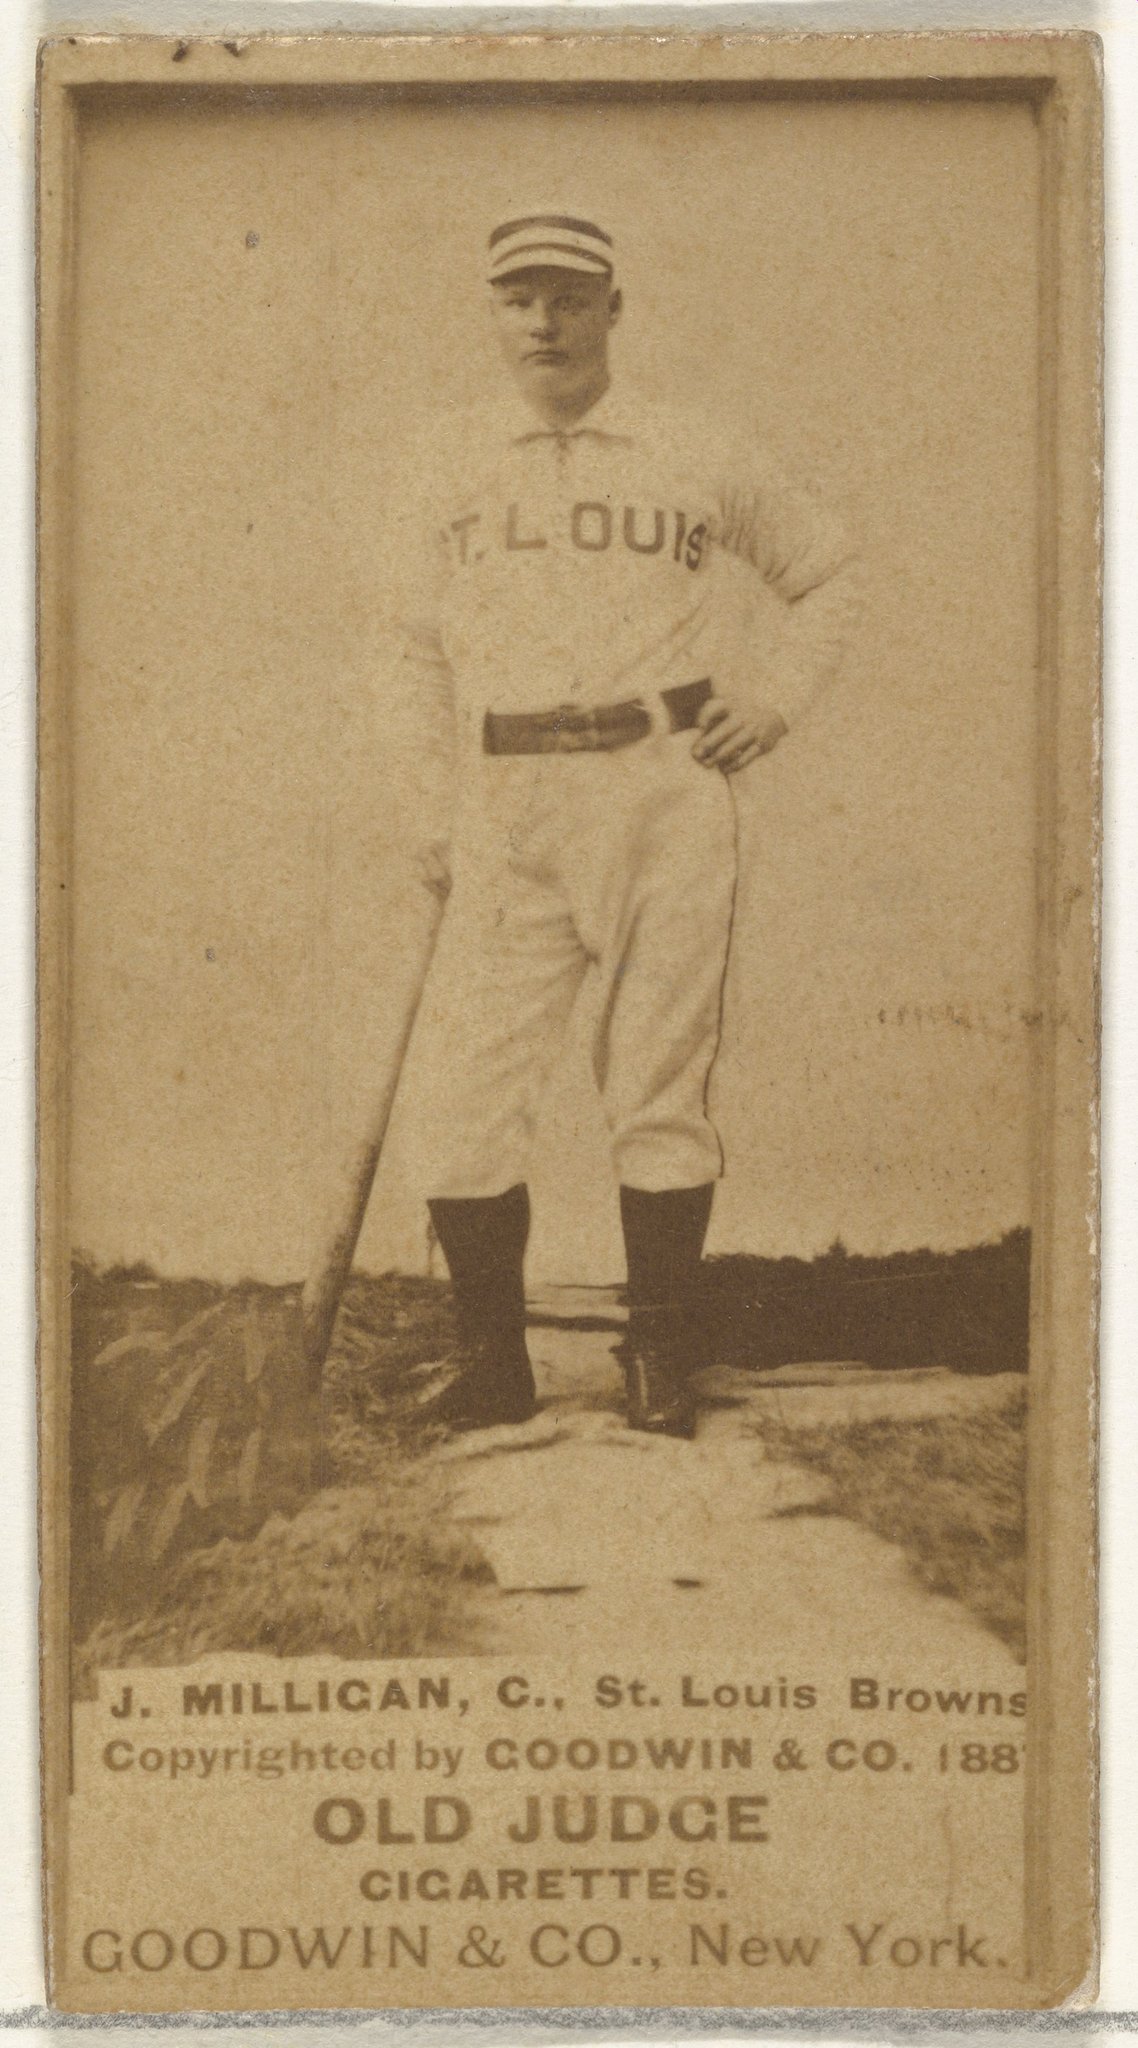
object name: baseball card, photograph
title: Jocko Milligan, Catcher, St. Louis Browns, from the Old Judge series (N172) for Old Judge Cigarettes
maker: goodwin & company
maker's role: publisher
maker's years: 1850-1950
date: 1887-1890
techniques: albumen silver print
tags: men,portraits,baseball,athletes